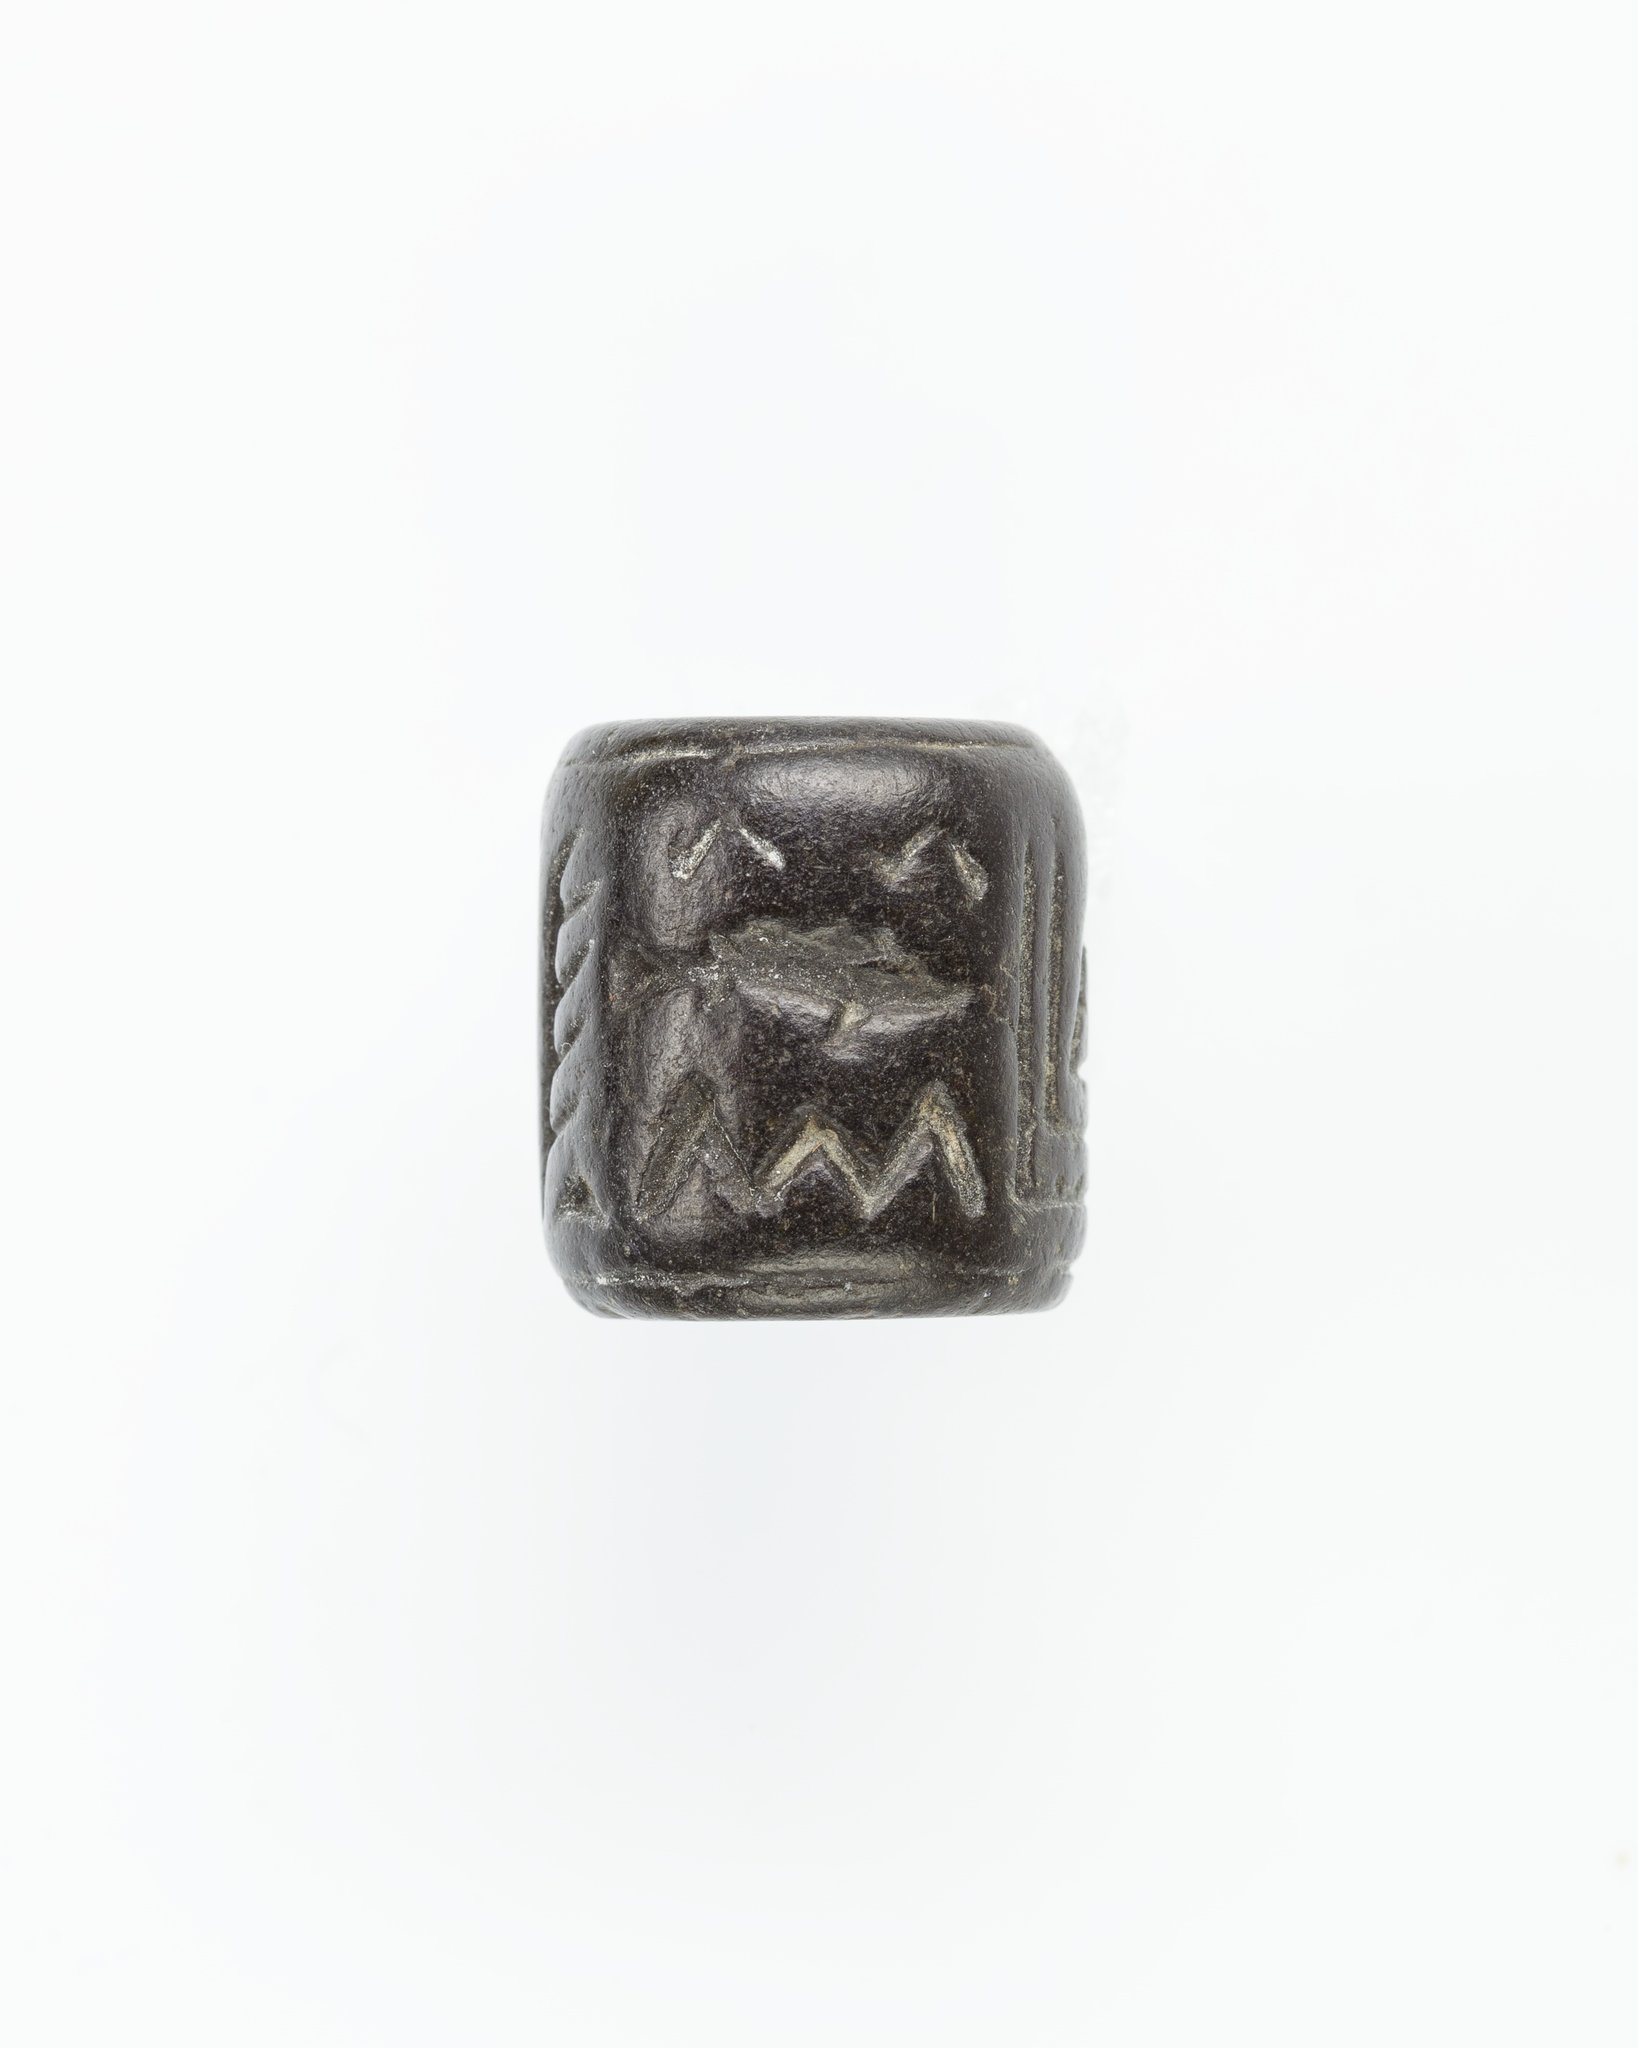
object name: cylinder seal, neit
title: Cylinder seal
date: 2960-2649 BCE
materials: stone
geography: egypt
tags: hieroglyphs